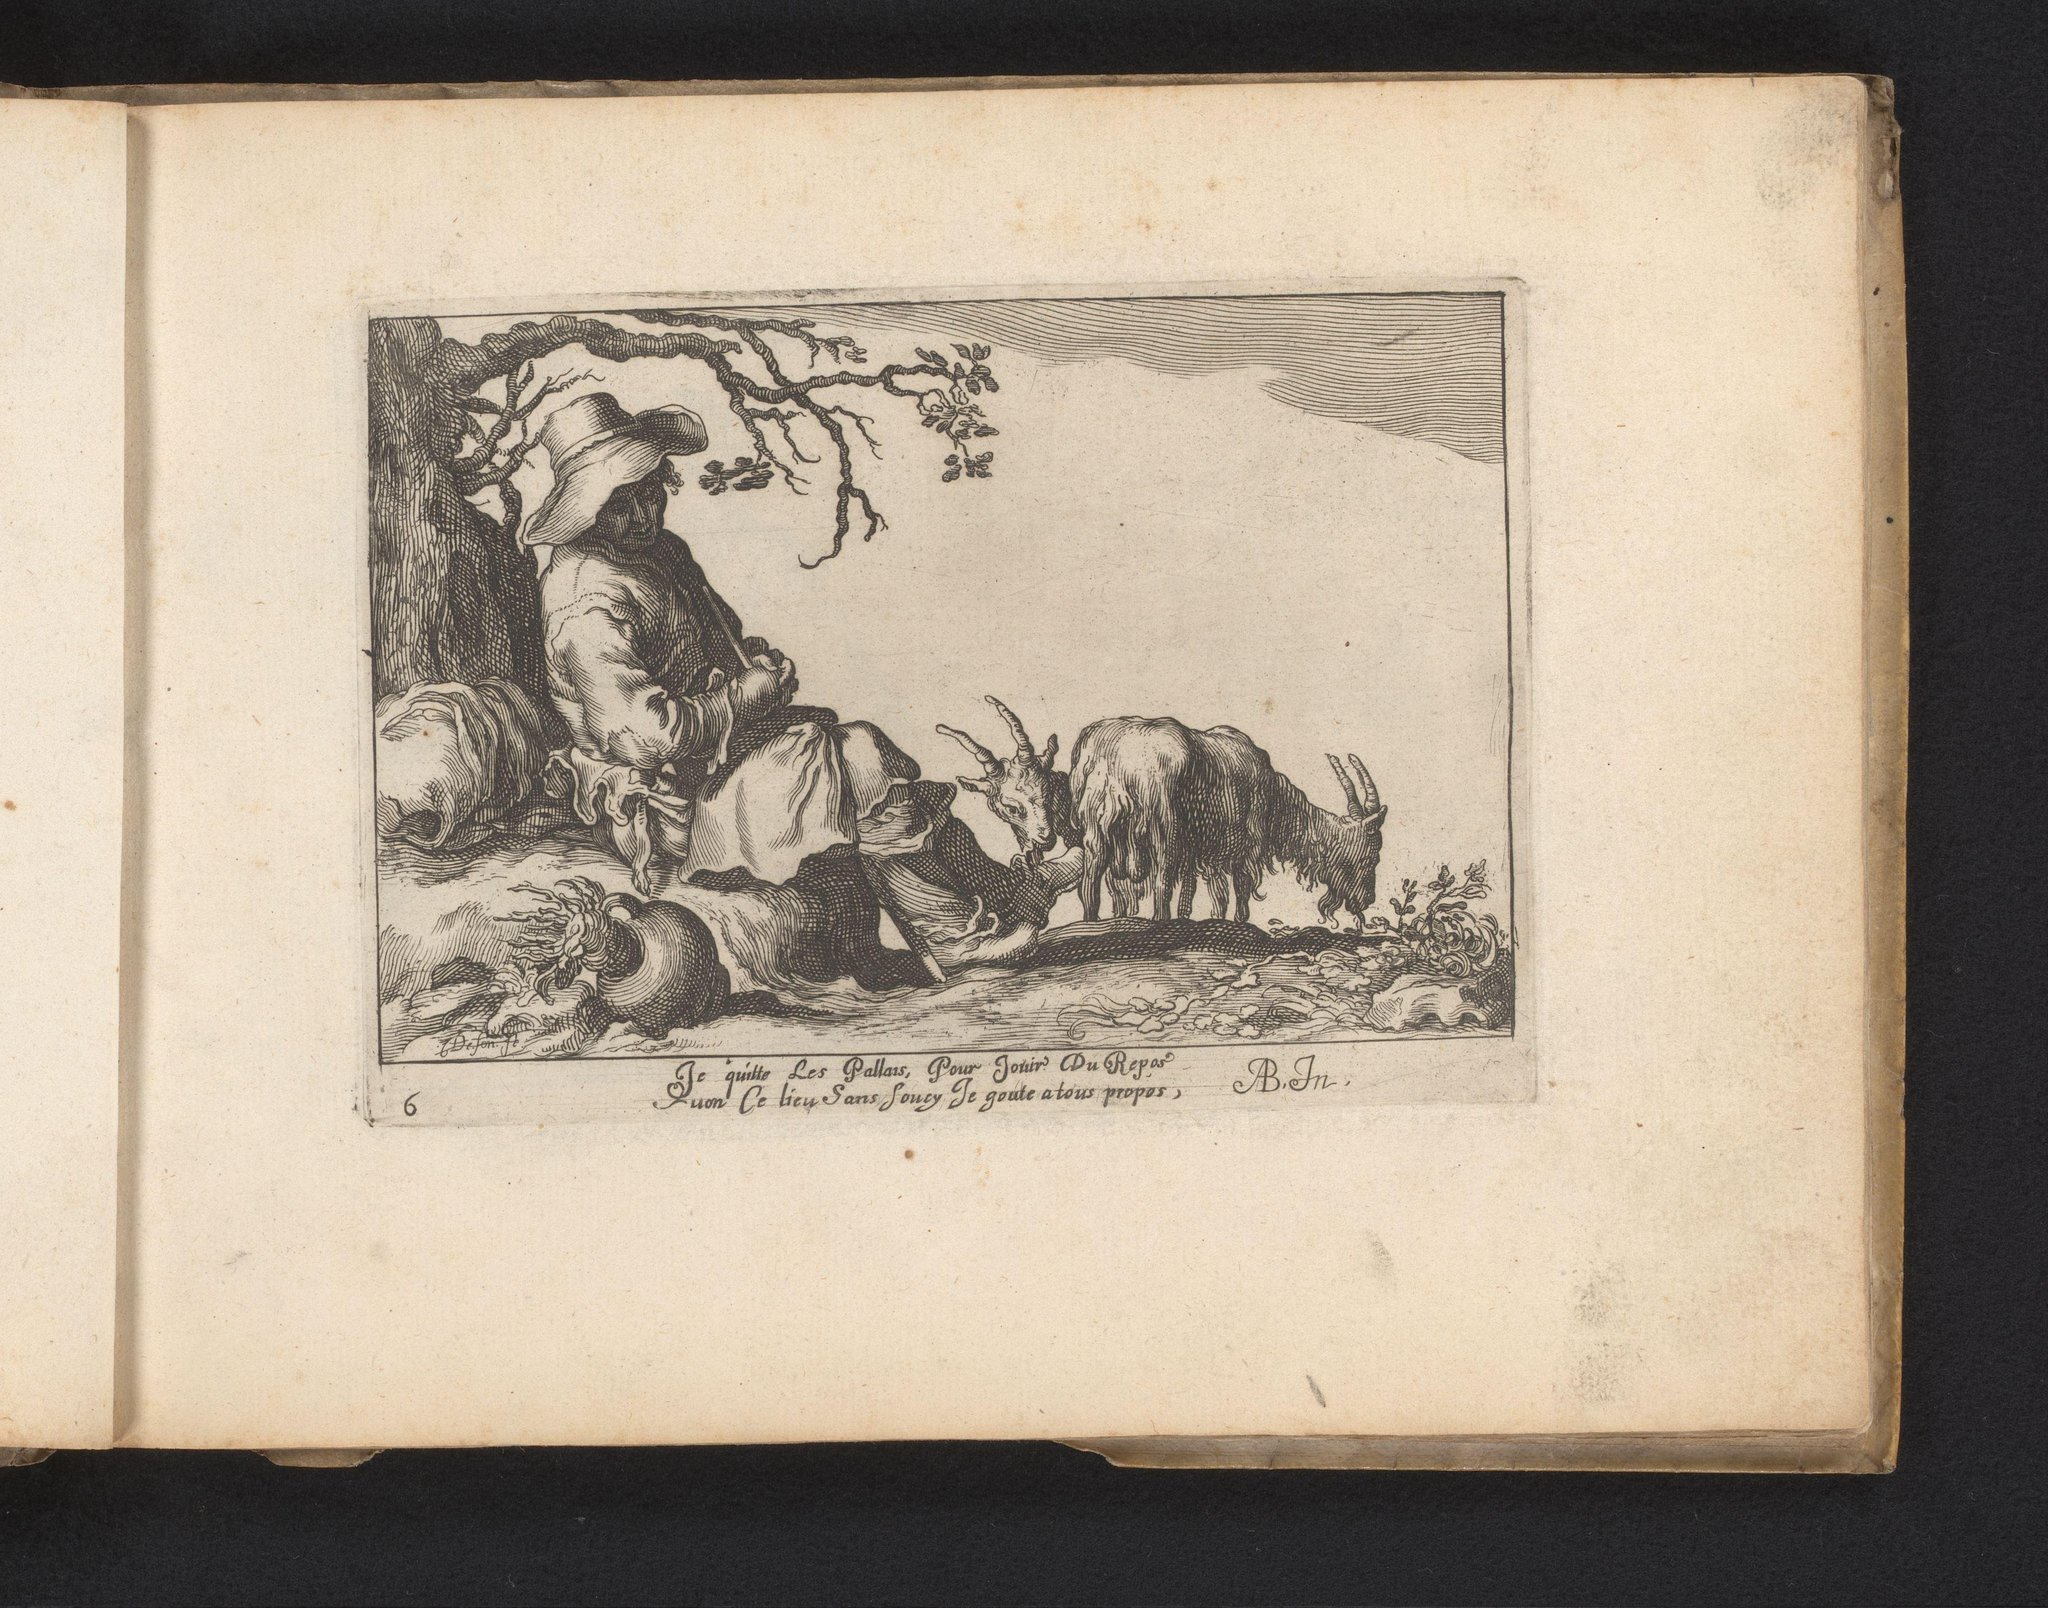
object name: print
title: Rustende herder met twee geiten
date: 1600-1650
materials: paper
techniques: etching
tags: herding, herdsman, herdswoman, shepherd, shepherdess, cowherd, etc., (traveller) resting in the open air, goat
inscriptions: collector's mark: ‘Bibliotheek/ Rijksmuseum/ Amsterdam’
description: Deze prent maakt deel uit van een album.